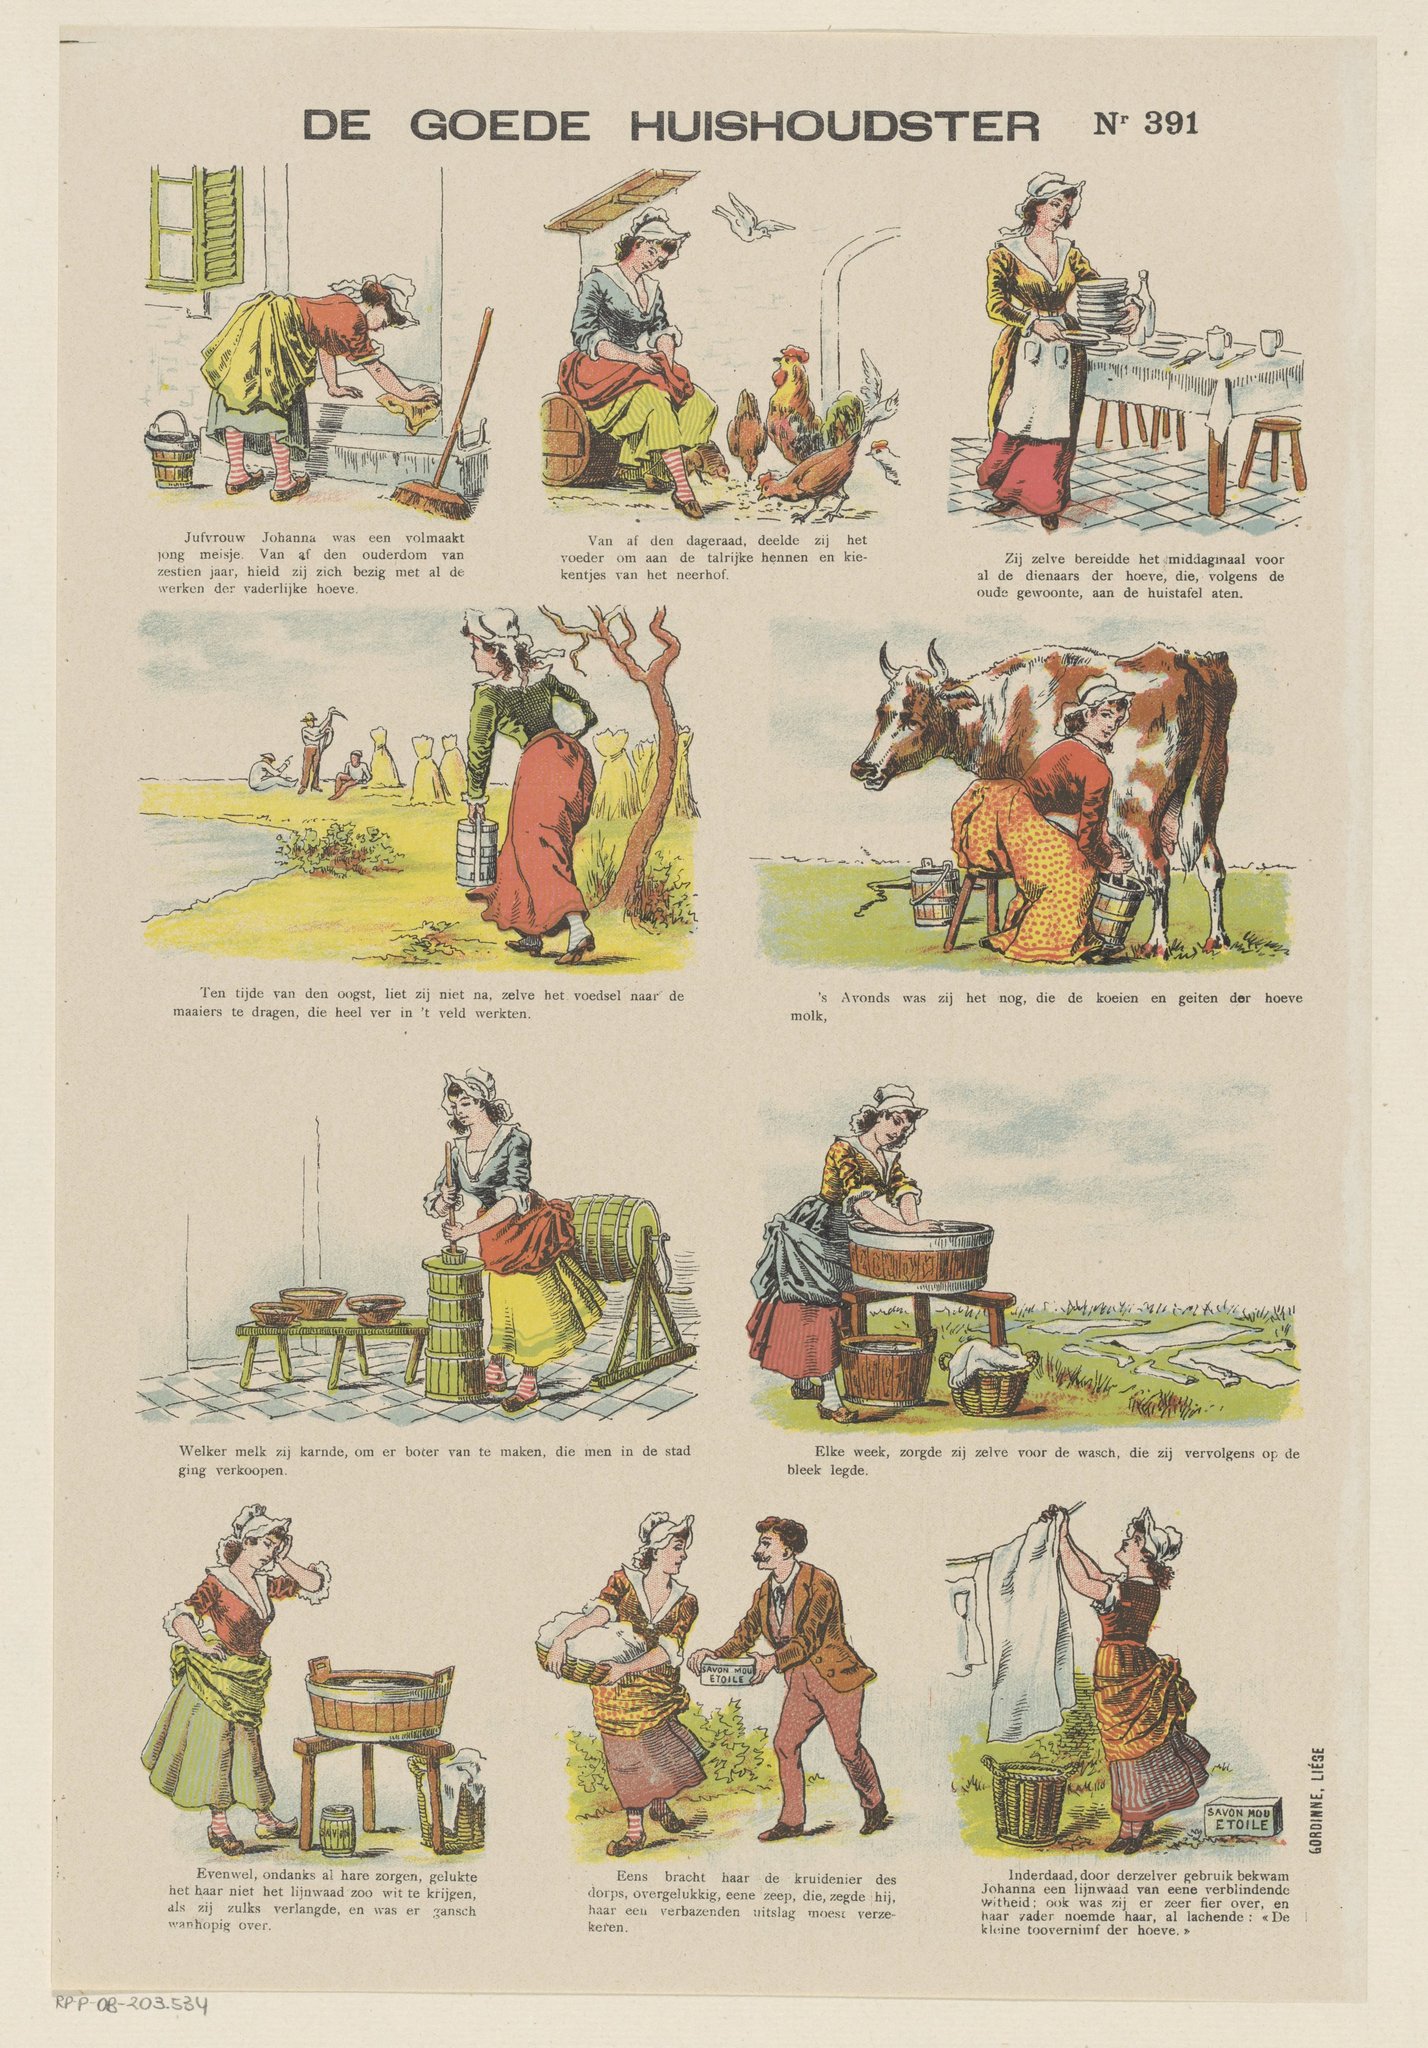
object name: print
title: De goede huishoudster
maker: Anonymous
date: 1894-1959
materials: paper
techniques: lithograph, letterpress printing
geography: liège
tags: maid ~ house personnel, household chores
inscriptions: collector's mark: Lugt 2760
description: Blad met 10 voorstellingen over de huishoudster Johanna die allerlei klusjes doet op de hoeve van haar vader. Onder elke afbeelding een onderschrift. Genummerd rechtsboven: No 391.